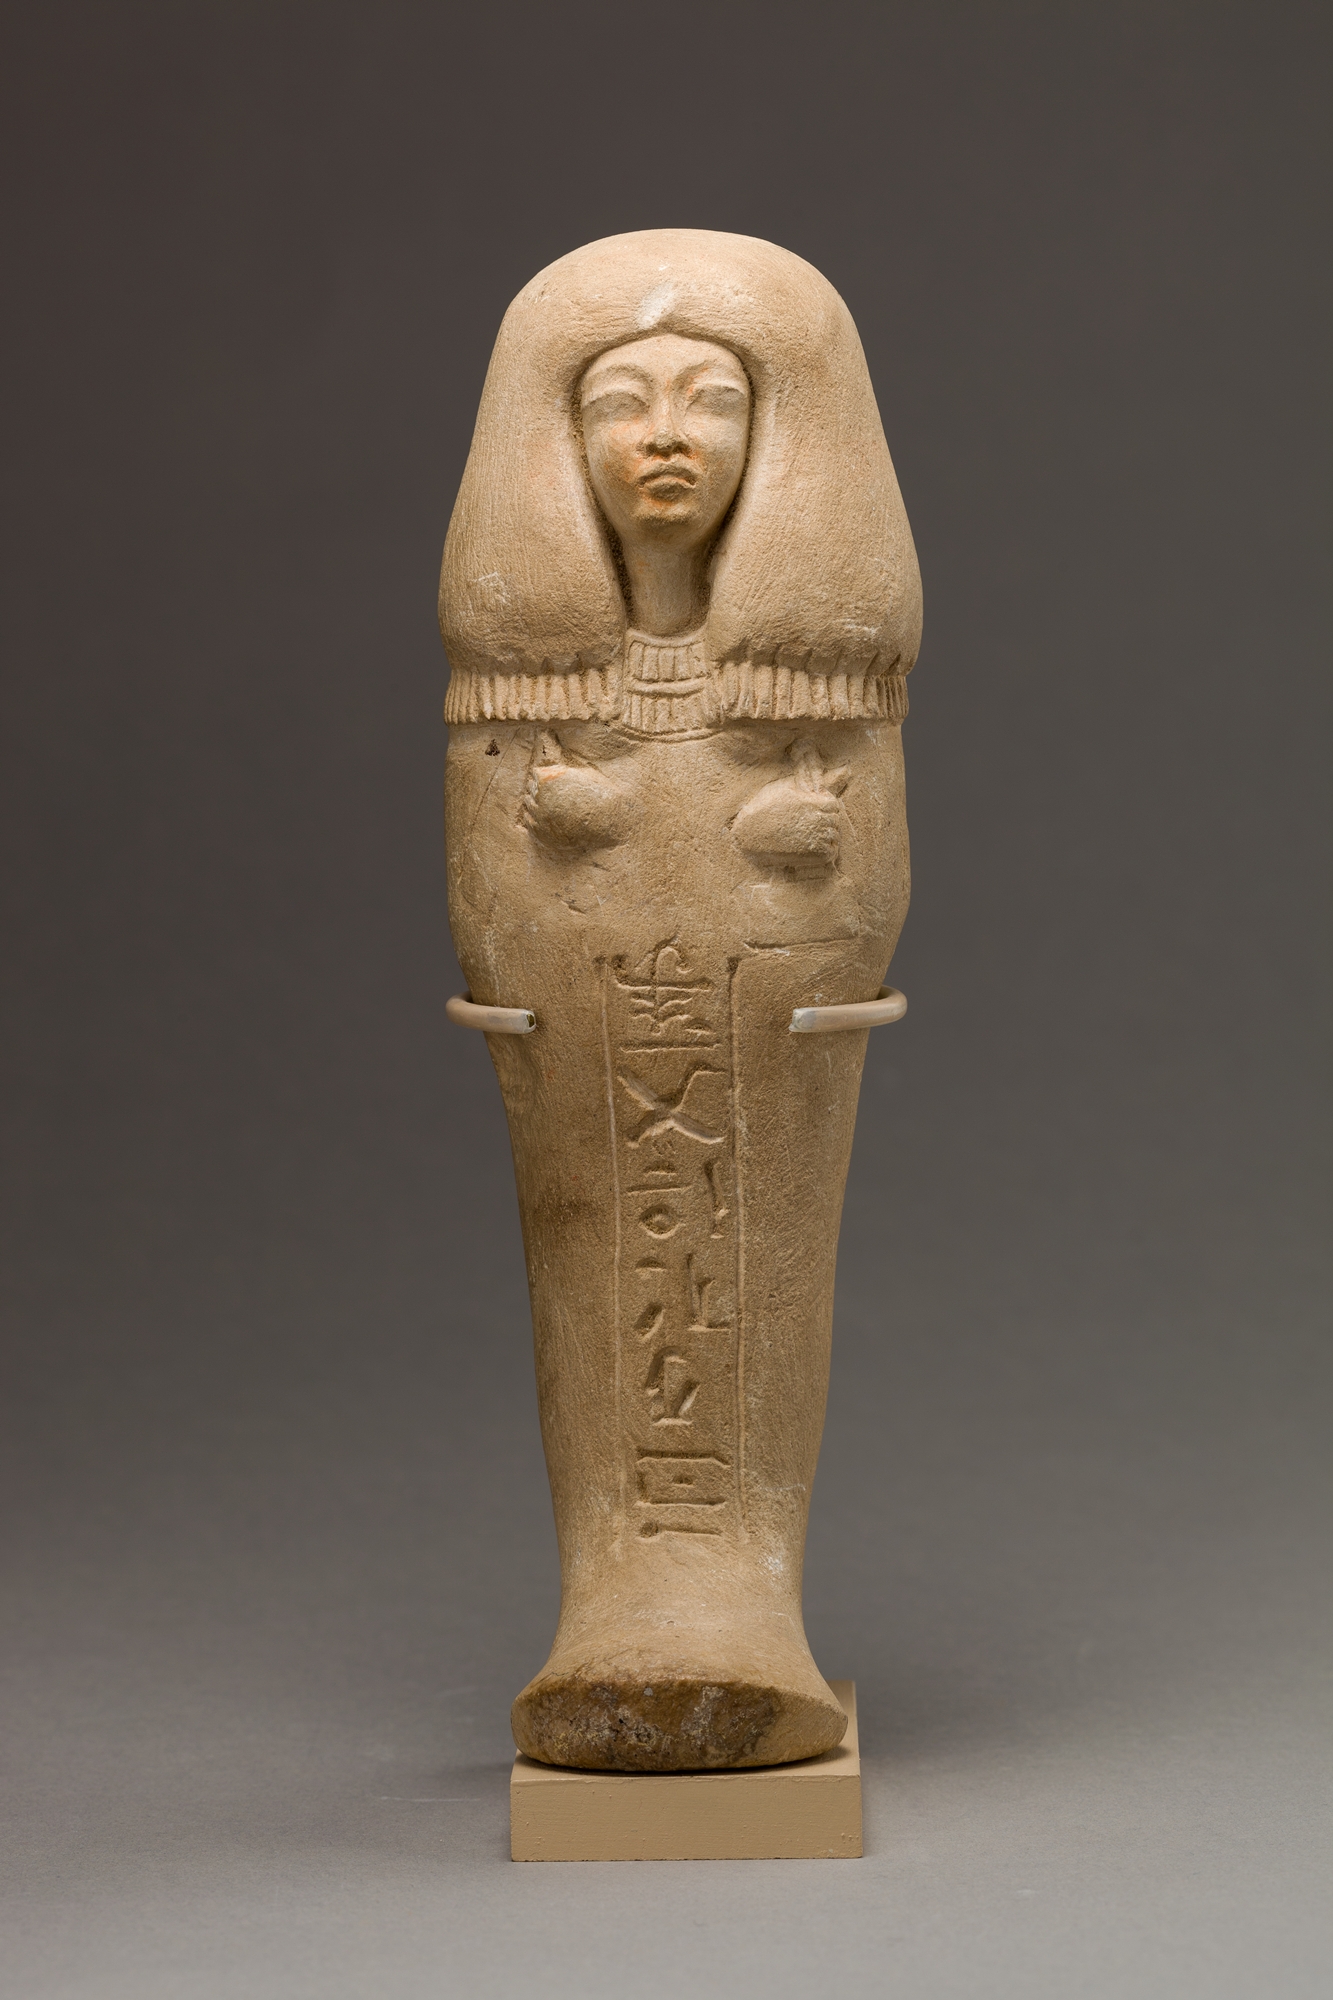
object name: funerary figure, shabti, isi, singer, aten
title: Funerary Figure of Isis, Singer of the Aten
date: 1353-1336 BCE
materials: limestone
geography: middle egypt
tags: isis